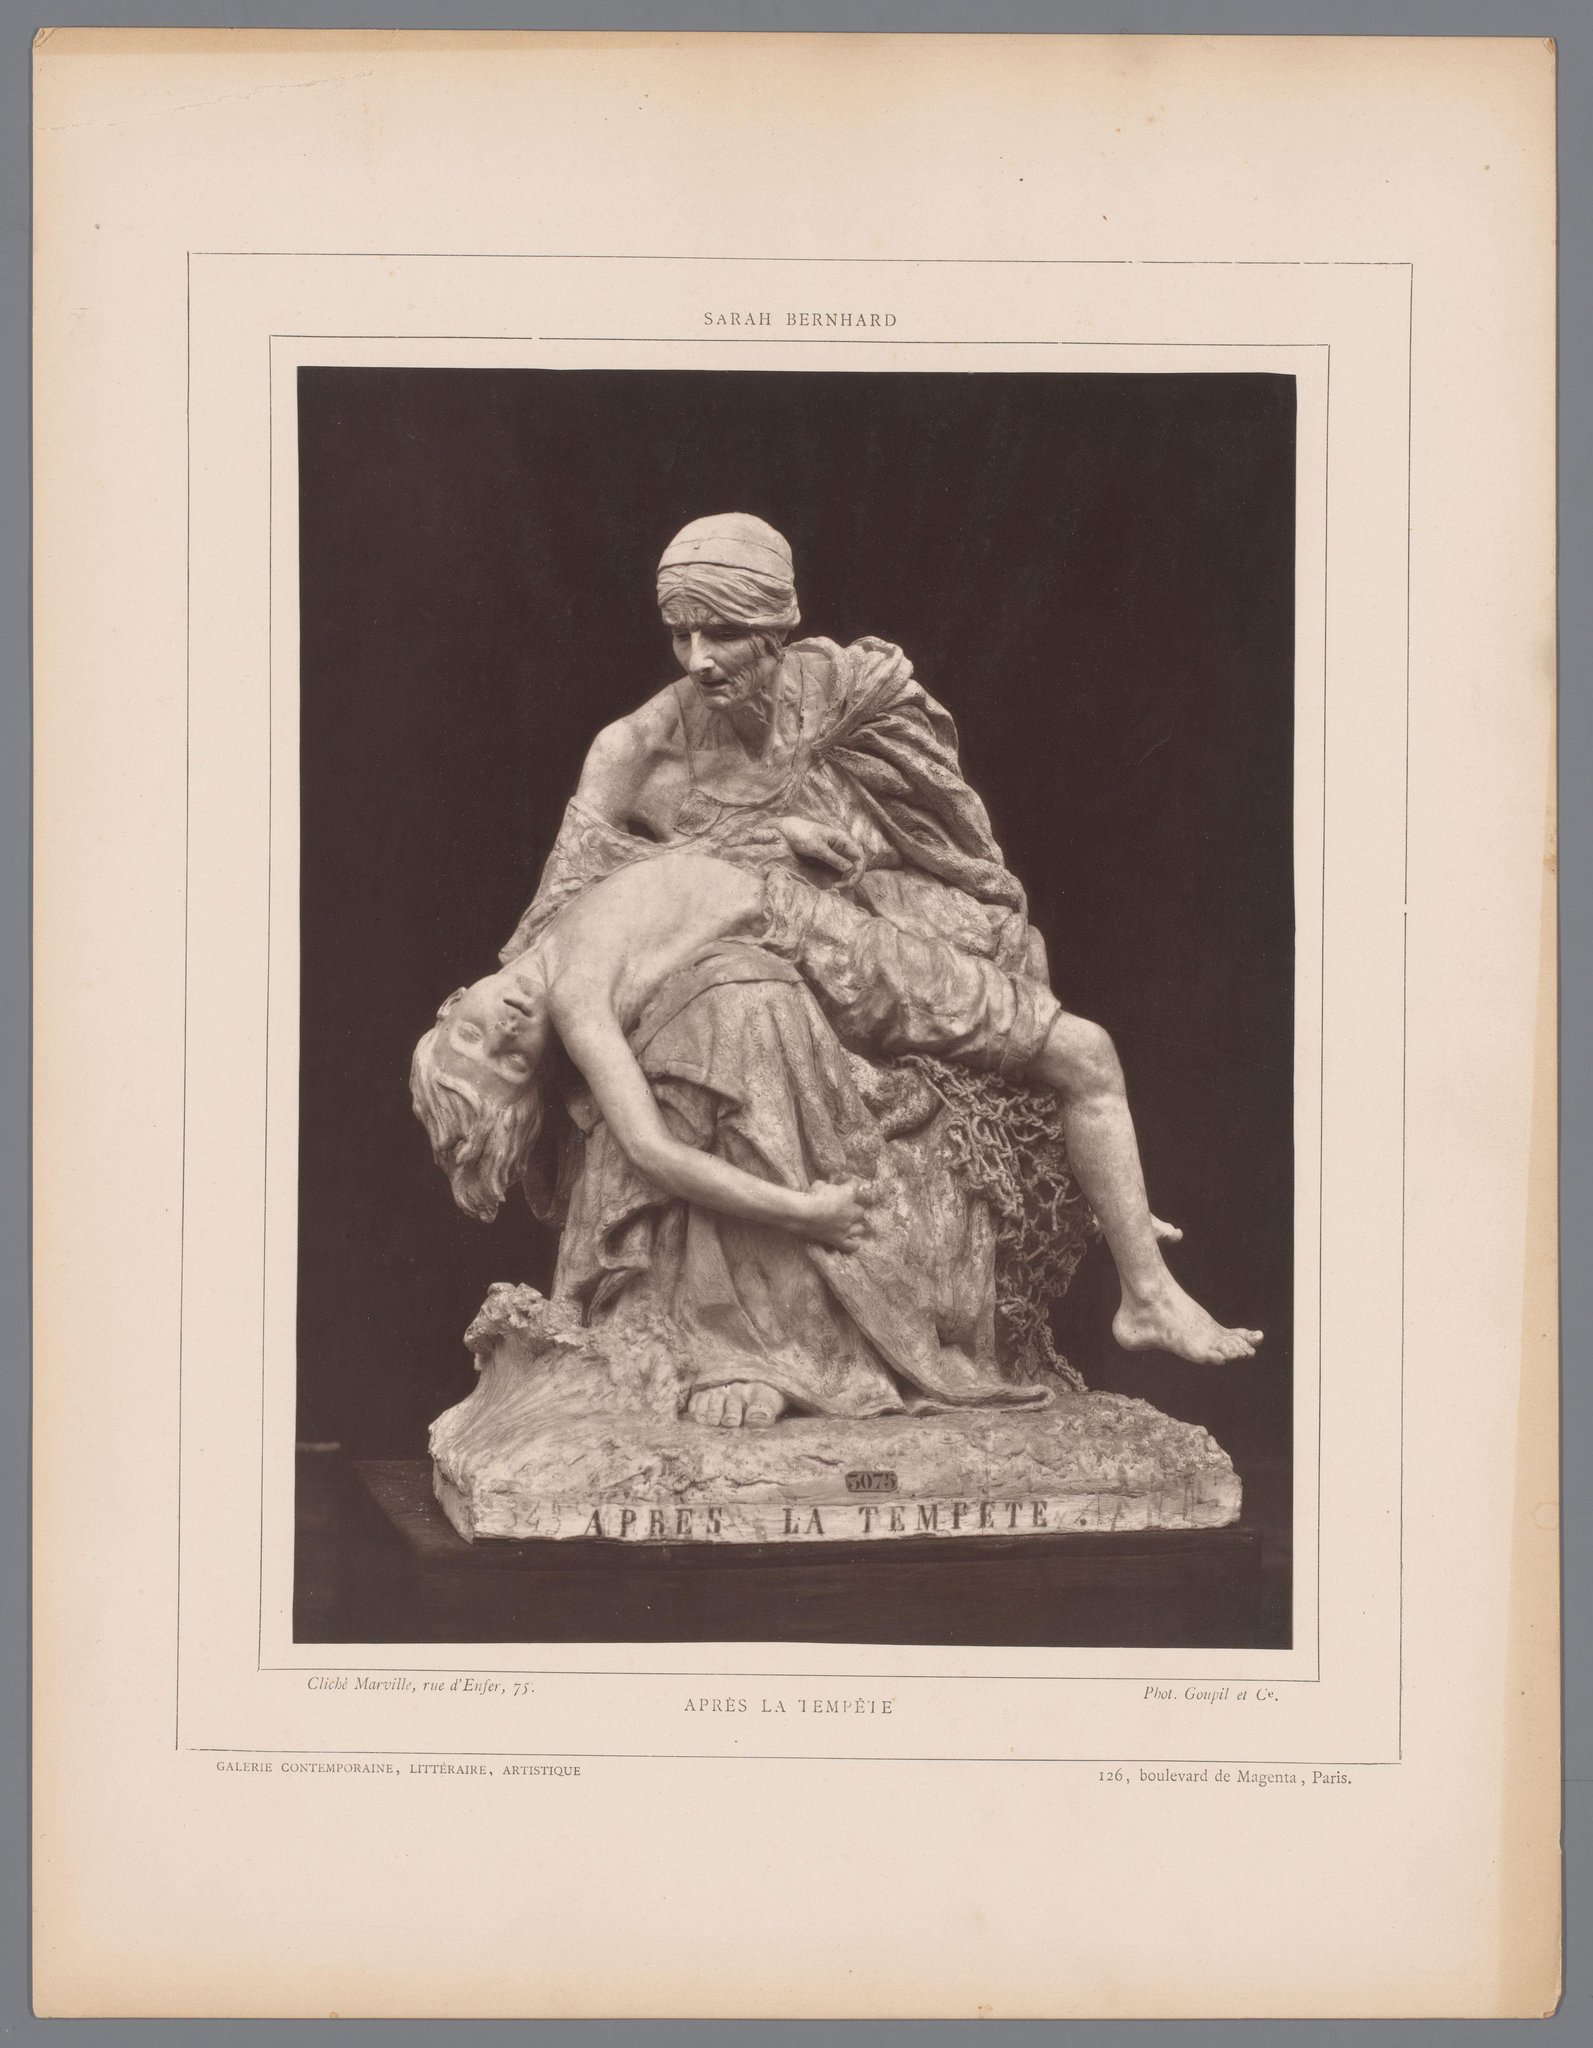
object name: photograph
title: Sculptuur 'Après La Tempête' van Sarah Bernhard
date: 1876-1884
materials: cardboard, paper, photographic support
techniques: woodburytype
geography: paris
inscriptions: caption: ‘APRÈS LA TEMPÊTE’, caption: ‘Phot. Goupil et Ce.’, caption: ‘Cliché Marville, rue d'Enfer, 75.’, caption: ‘GALERIE CONTEMPORAINE, LITTÉRAIRE, ARTISTIQUE.’, inscription: ‘SARAH BERNHARD’, caption: ‘126 boulevard Magenta, Paris.’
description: Foto van sculptuur Après la Tempête, een piétà-voorstelling: moeder met de dode Christus (?) op haar schoot. Plaat uit tijdschrift.